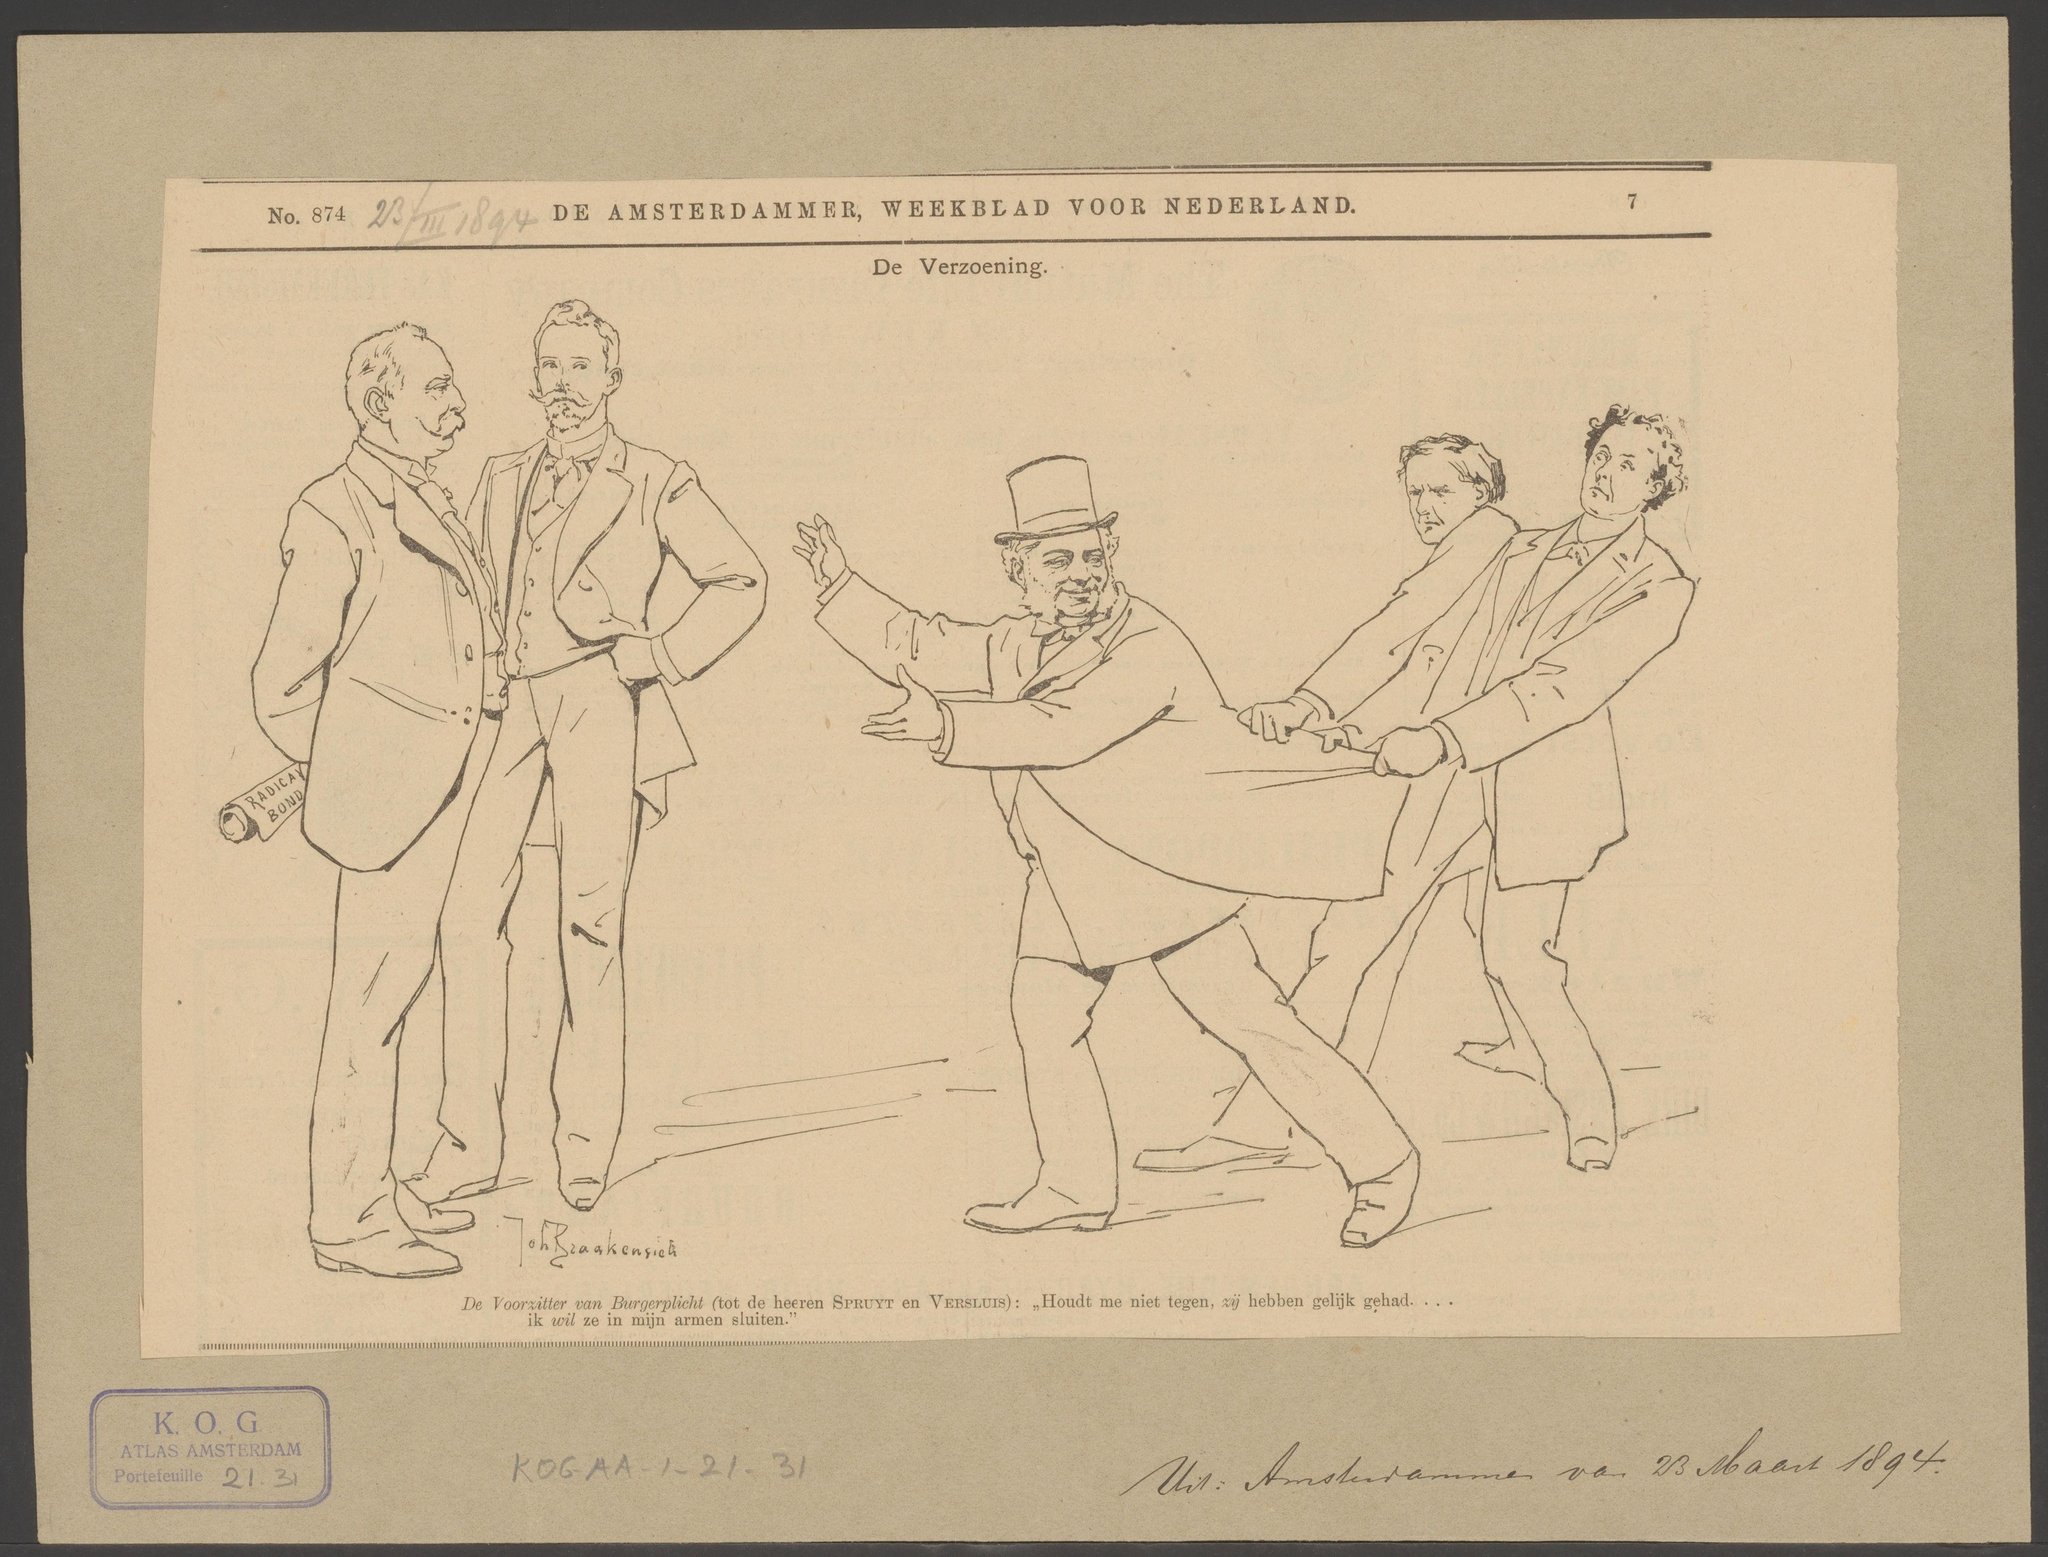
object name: photomechanical print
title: De Verzoening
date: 1894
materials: paper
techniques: letterpress printing, line block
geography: amsterdam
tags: politician, politician, e.g. party leader, political caricatures and satires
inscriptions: collector's mark: Lugt 1641b, date: ‘23/III 1894’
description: Onderwerpsrubriek binnen de Atlas Amsterdam: Kiesverenigingen, Politieke partijen.